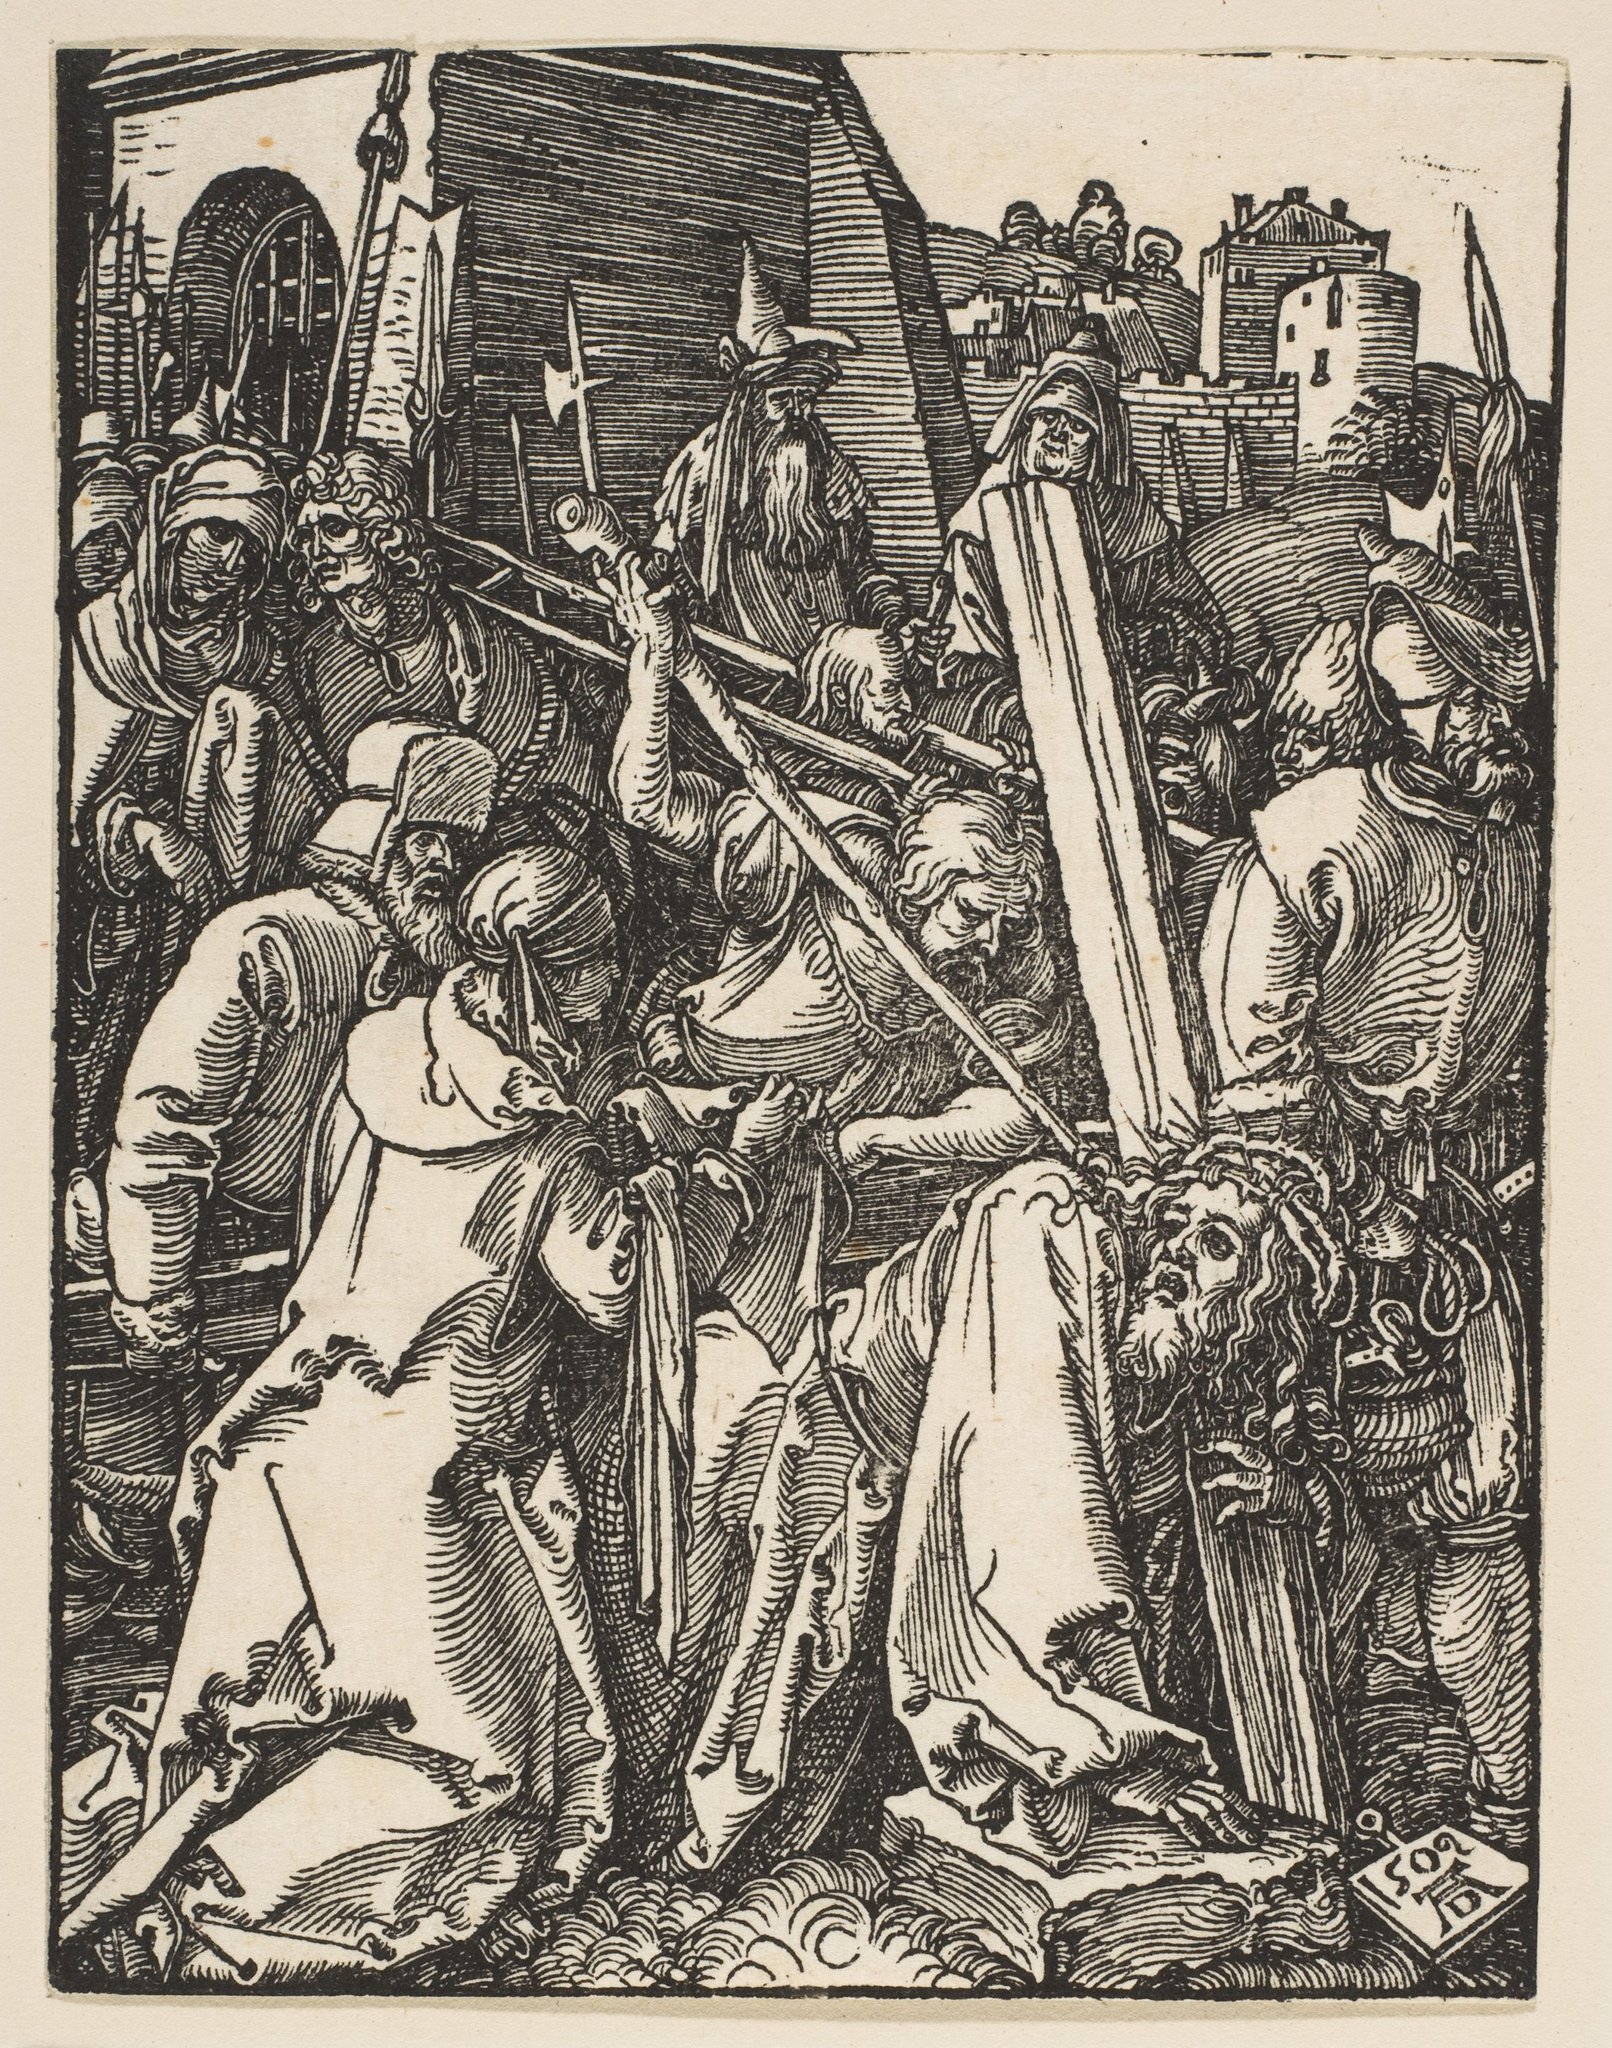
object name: print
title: Chist Carrying the Cross, from "The Small Passion"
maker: albrecht dürer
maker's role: artist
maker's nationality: german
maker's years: 1471-1528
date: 1509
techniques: woodcut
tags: weapons,suffering,men,christ,cross